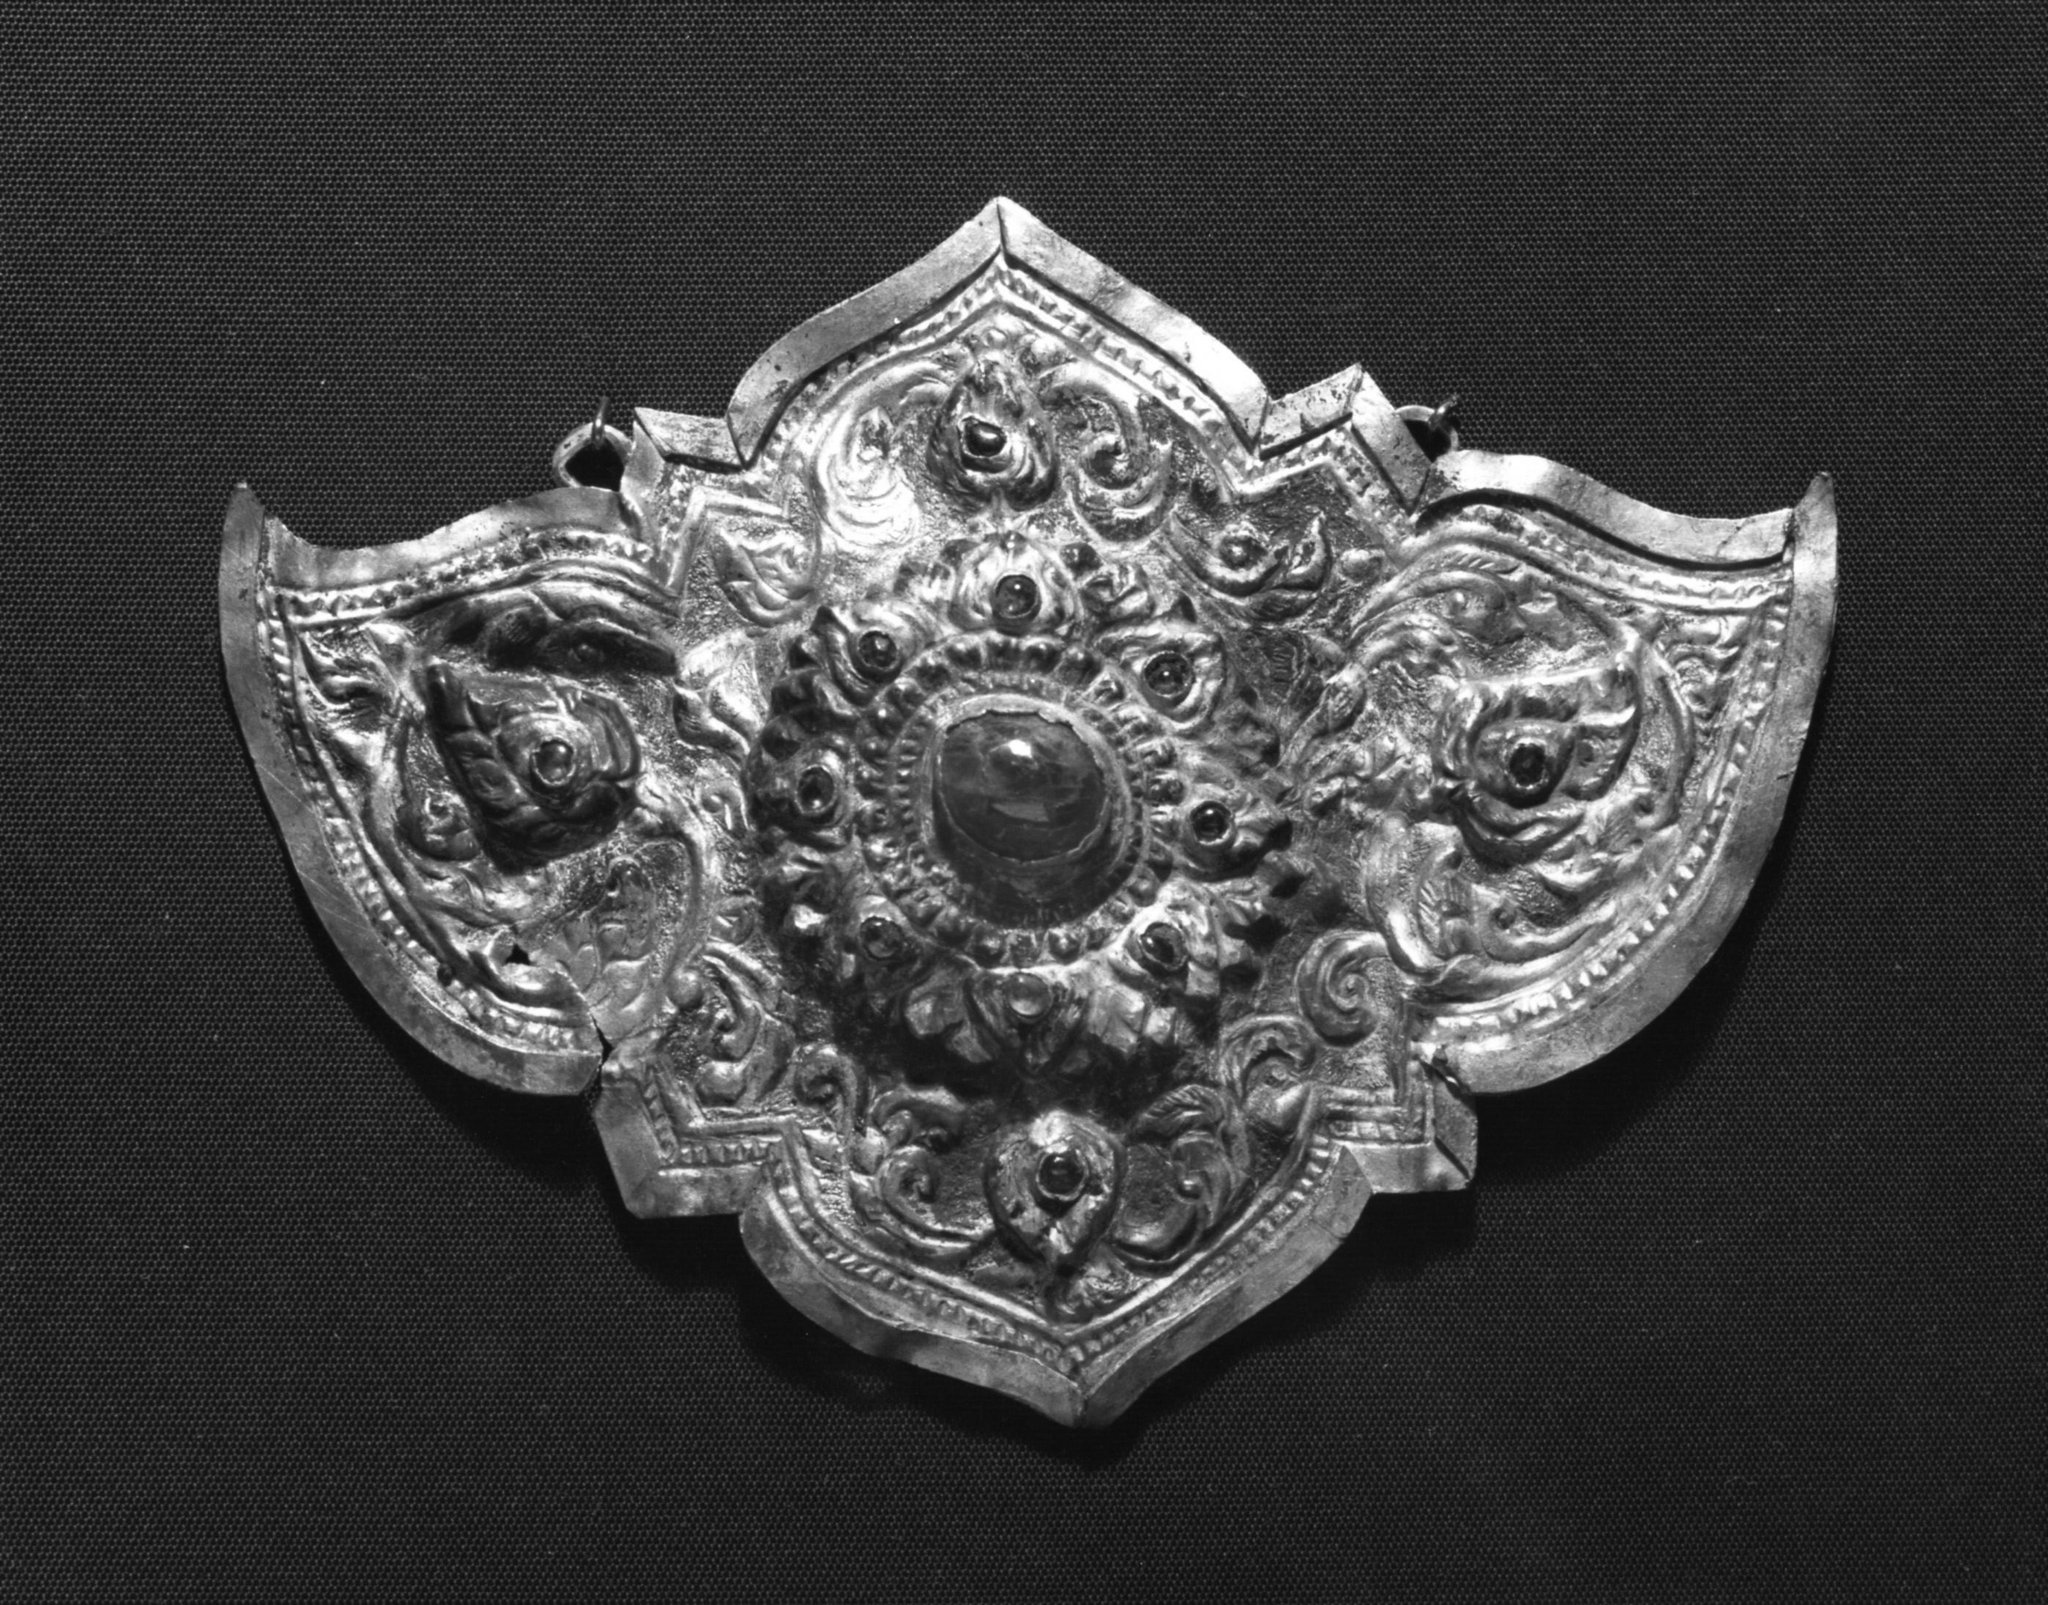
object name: pendant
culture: thai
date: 1401-1433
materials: gold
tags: flowers